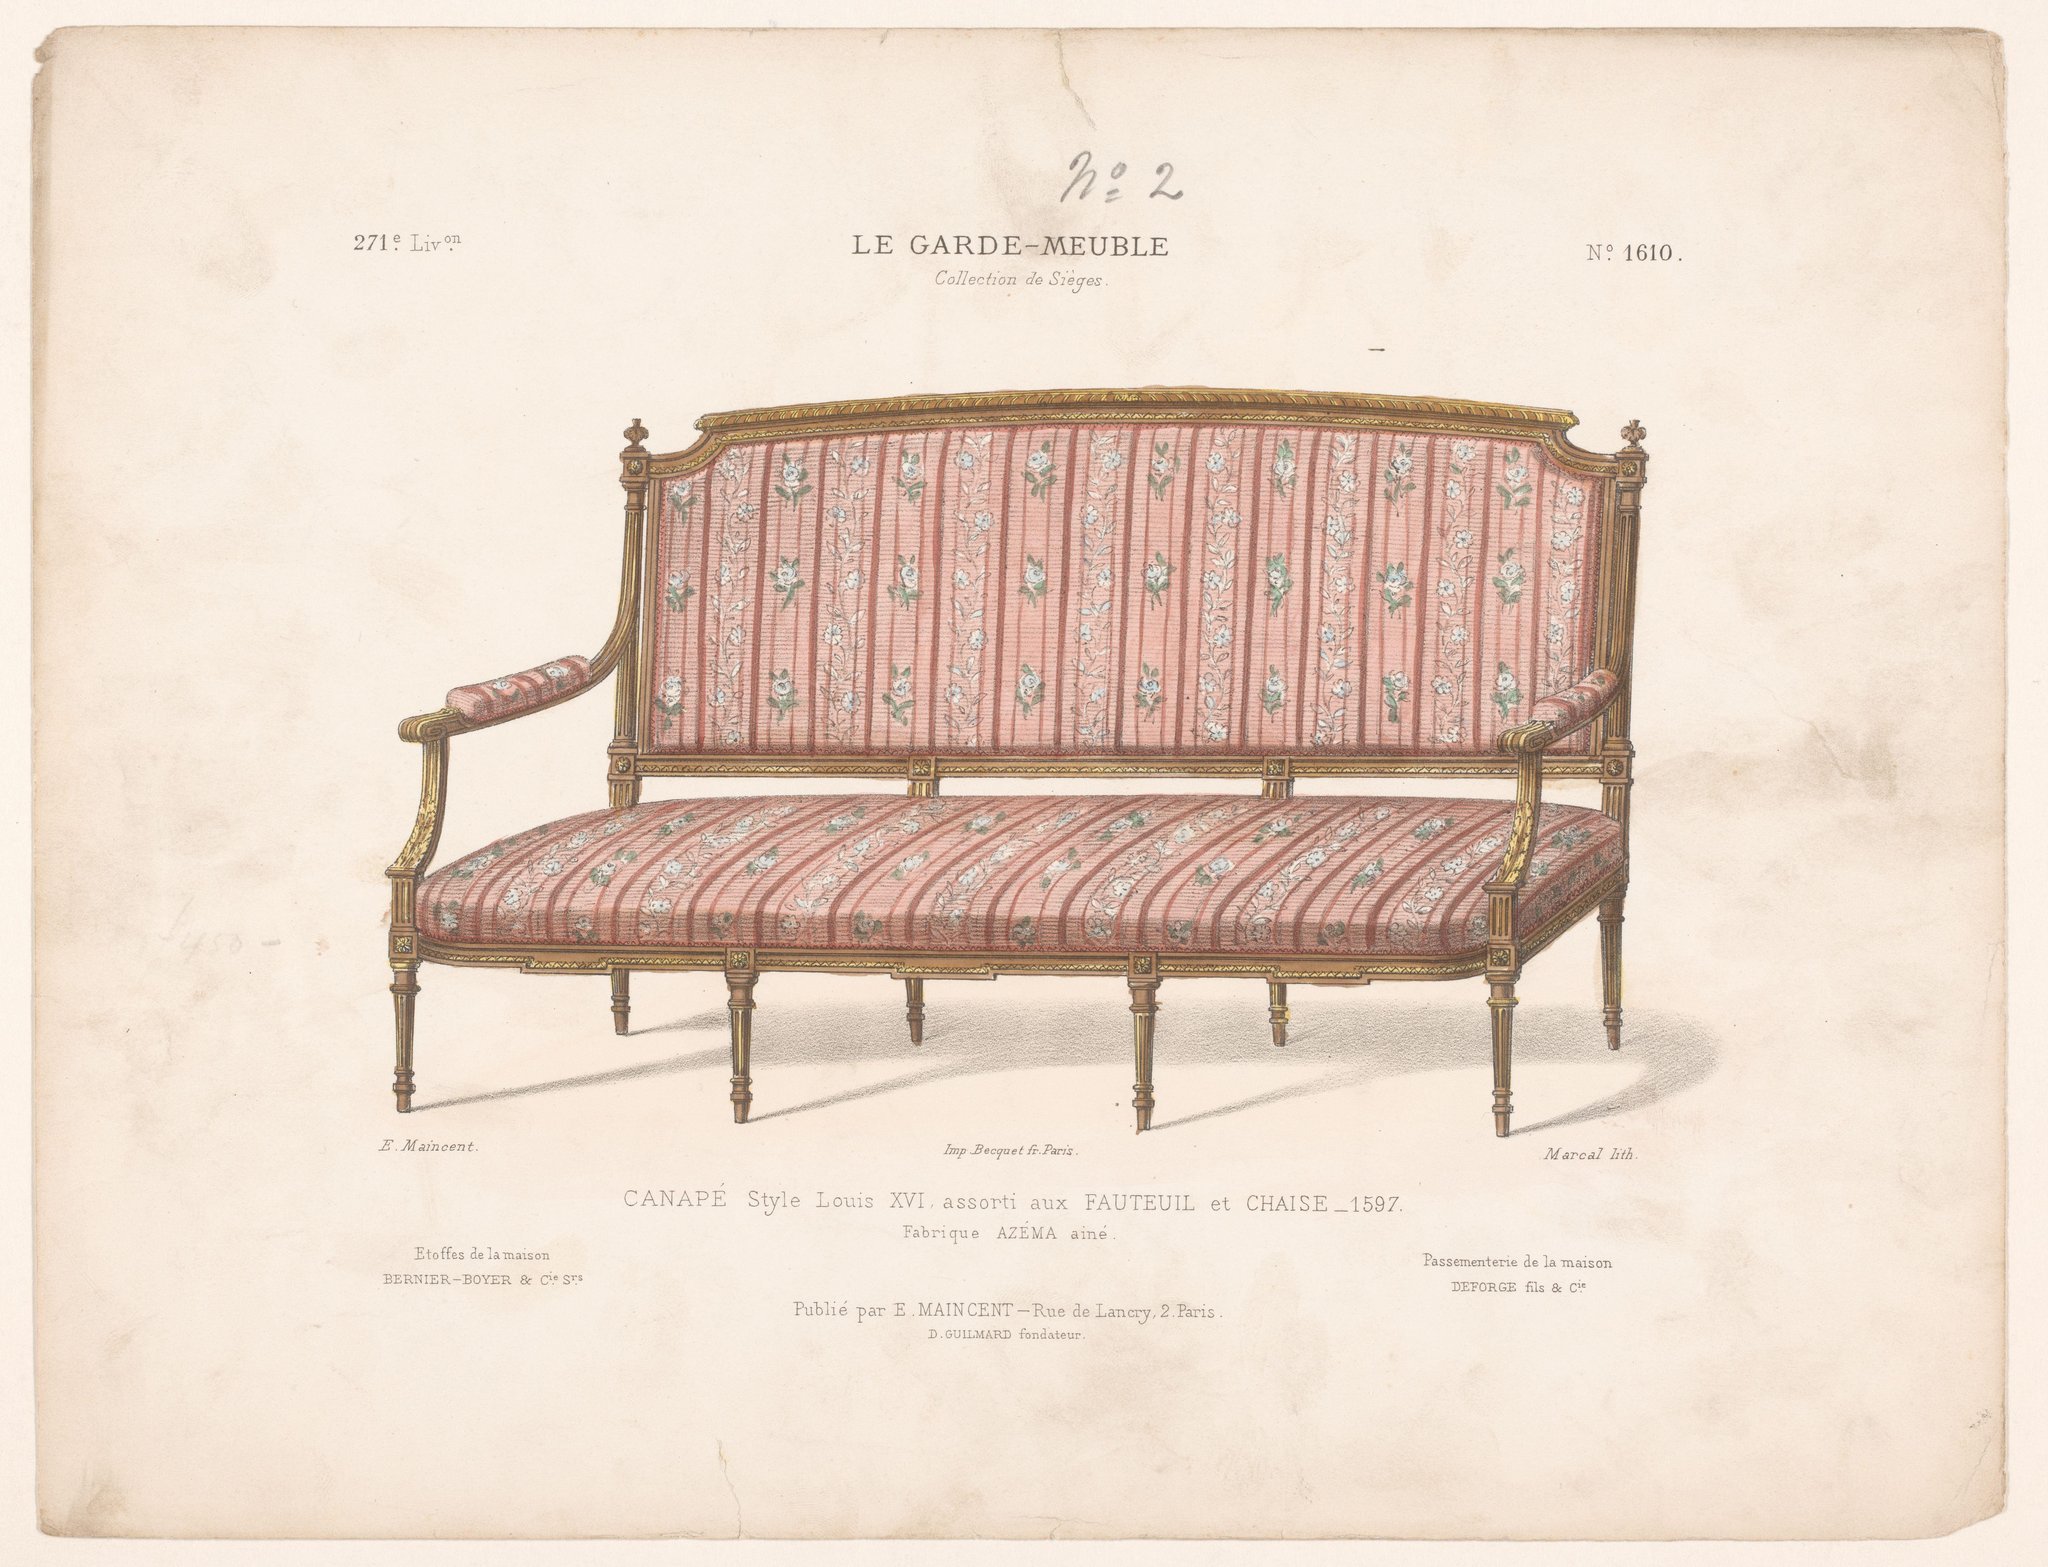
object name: print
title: Canapé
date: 1885-1895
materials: paper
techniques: hand coloring, lithograph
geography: paris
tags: seating furniture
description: Ieder Livraison in de serie Le Garde-Meuble bevat negen platen: drie 'sièges' (zitmeubels), drie 'meubles' (diverse meubels zoals tafels en kasten) en drie 'tentures' (gordijnen en draperieën).